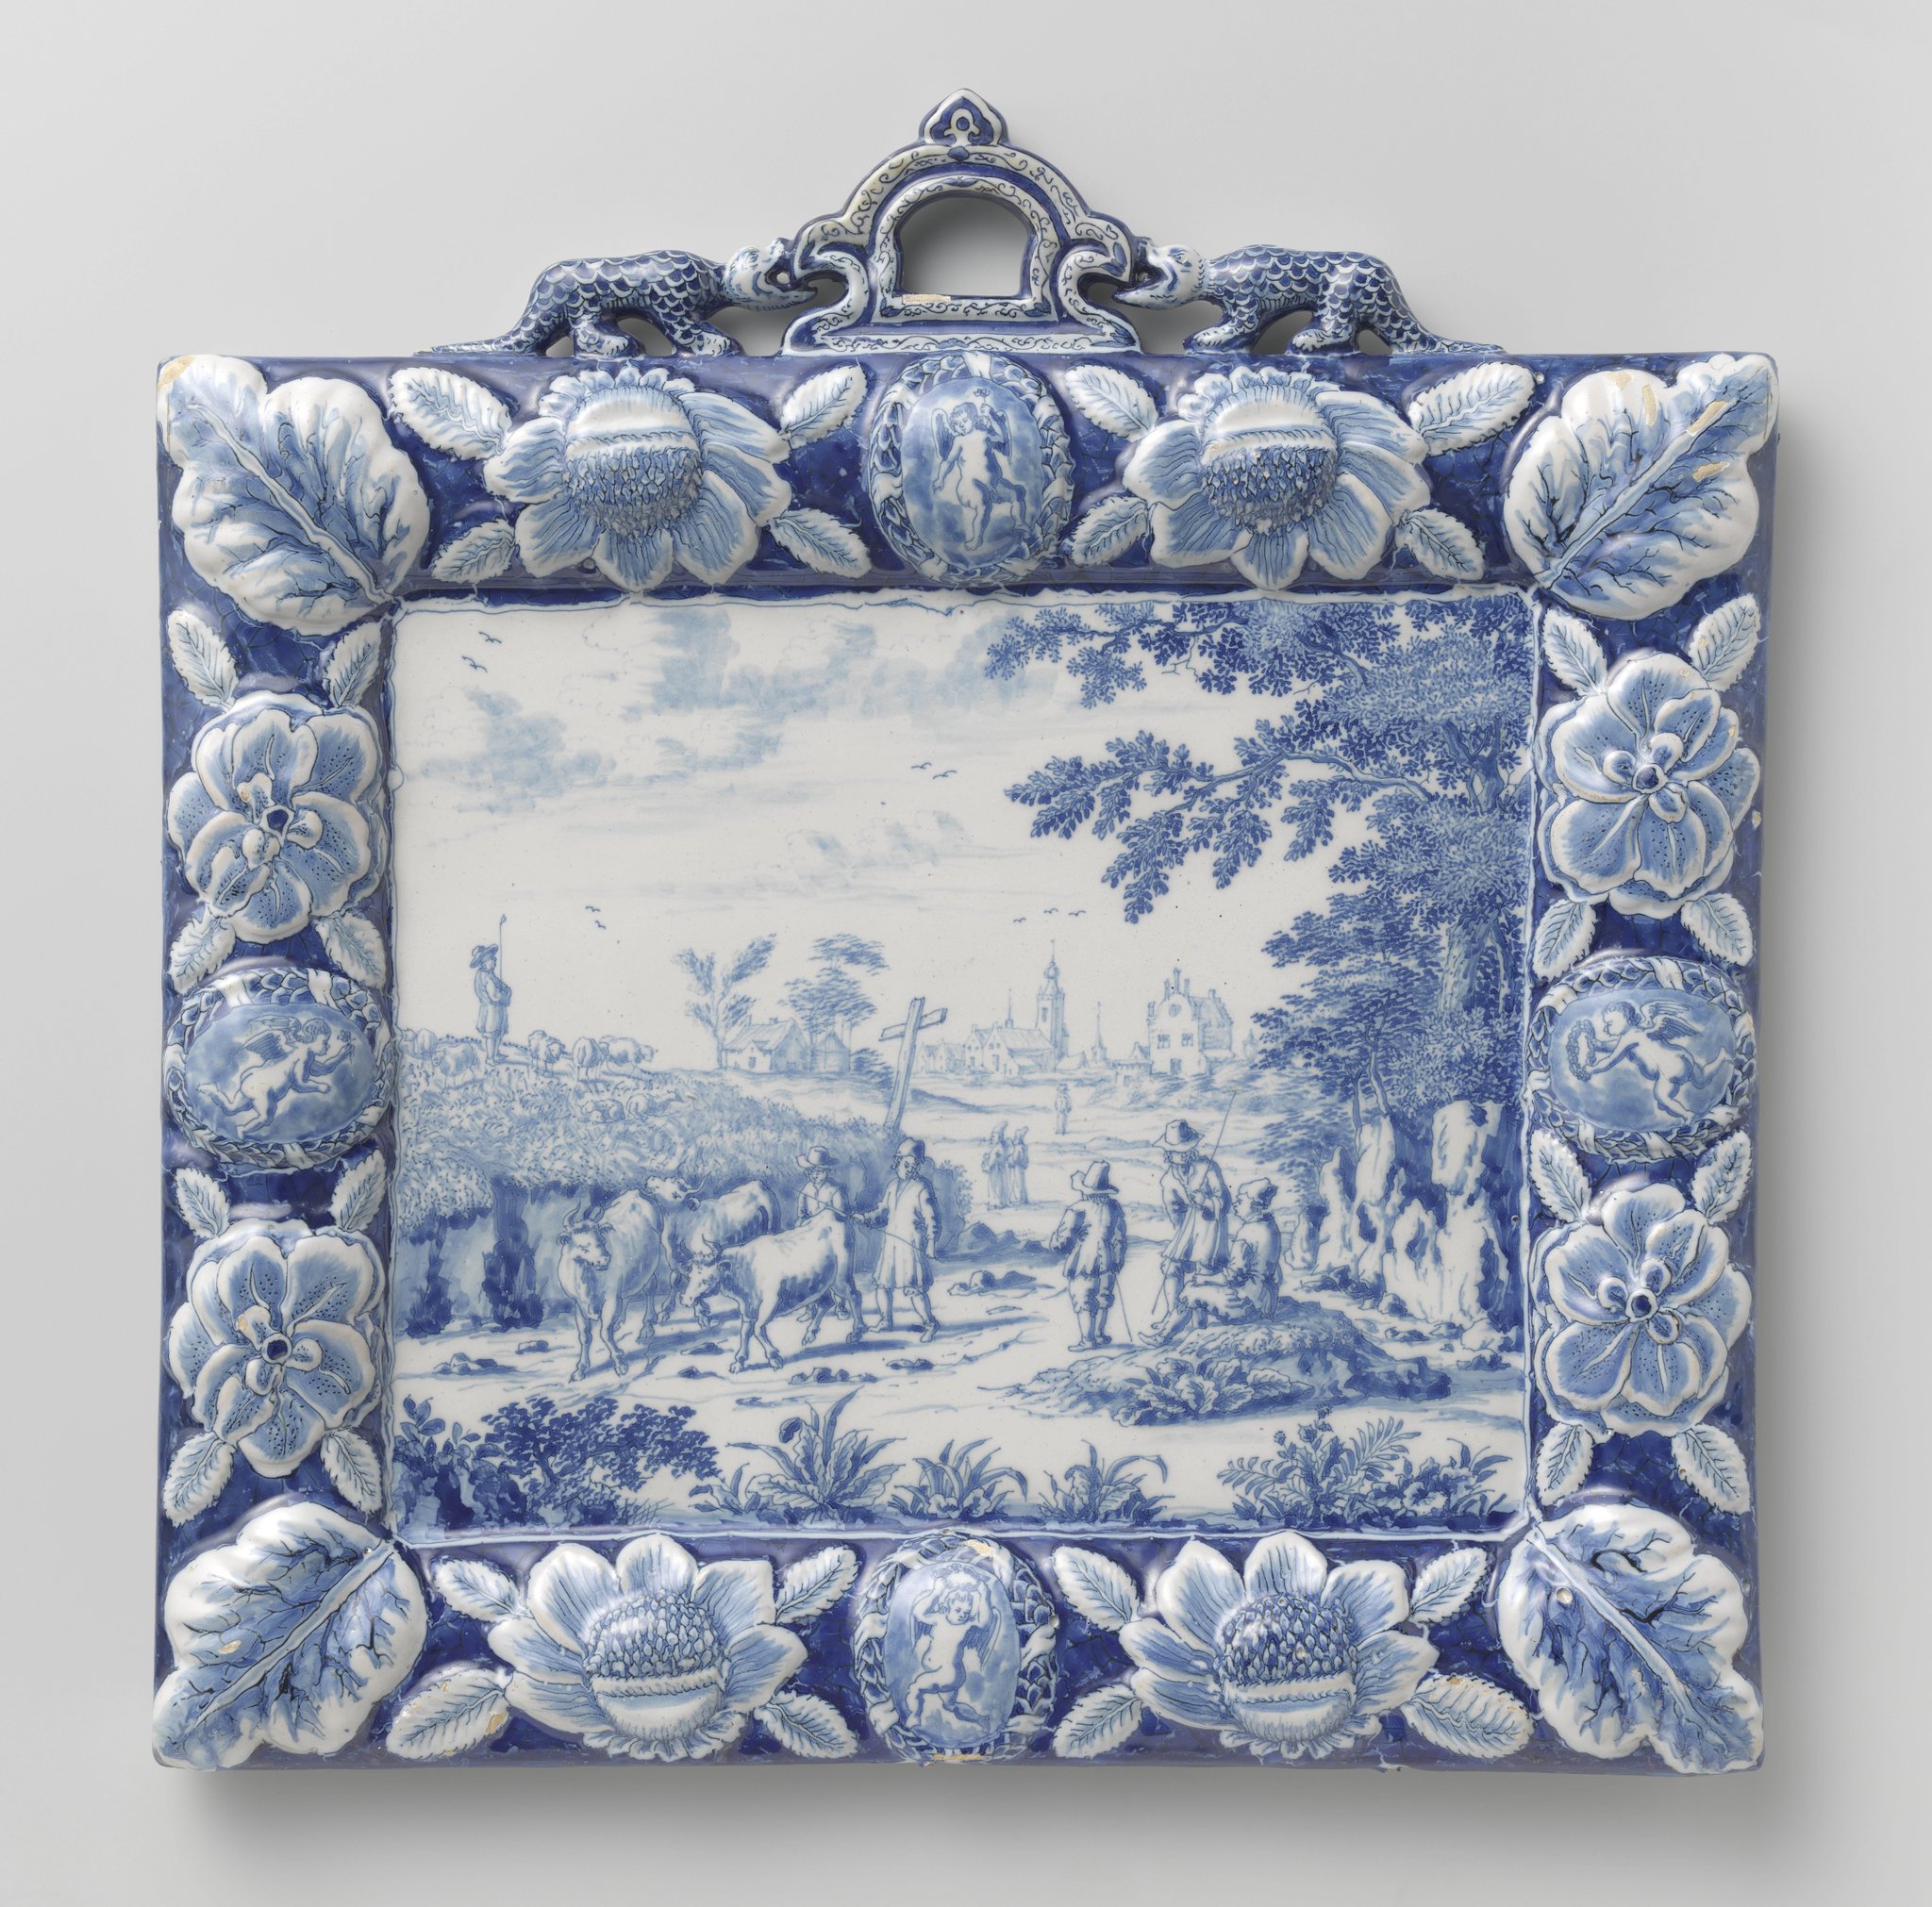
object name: plate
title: Two framed plaques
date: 1690-1705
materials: earthenware, glaze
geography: delft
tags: herding, herdsman, herdswoman, shepherd, shepherdess, cowherd, etc., landscapes in the temperate zone, cattle driving, cattle driver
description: These plaques were made as ready-to-display faience paintings. The ornamental frames, plaques and hooks form a whole. Being of earthenware, the plaques could be hung in places that were not suitable for ordinary paintings, such as walls flooded with light or kitchens.